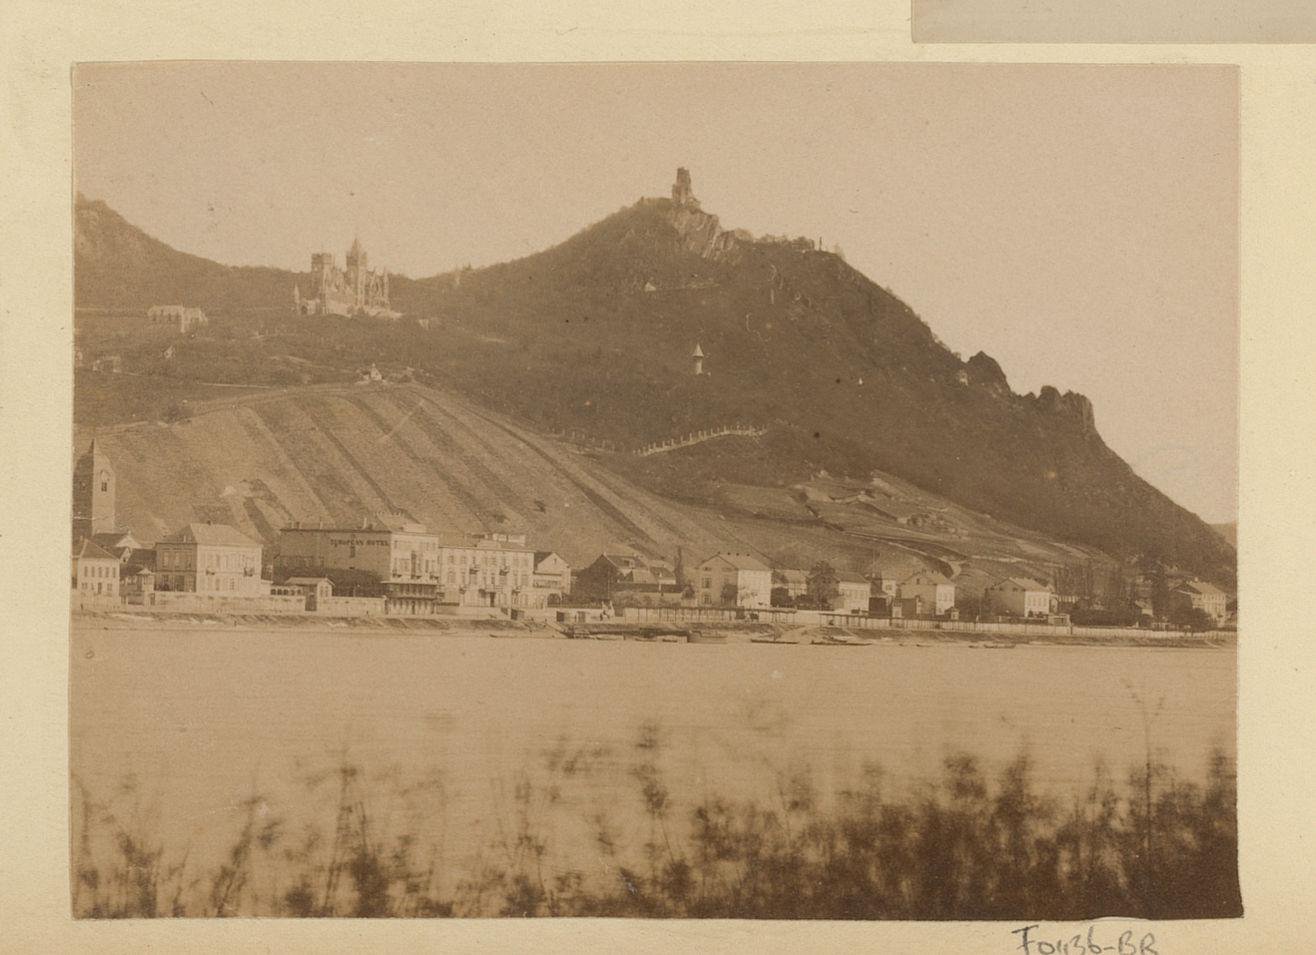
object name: photograph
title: Gezicht op Königswinter am Rhein en de Drachenfels met Schloss Drachenburg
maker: Anonymous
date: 1880-1895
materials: photographic support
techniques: albumen print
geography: königswinter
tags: prospect of village, silhouette of village, river bank, mountains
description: Onderdeel van Fotoalbum met opnames van bezienswaardigheden in België, Duitsland en Noorwegen.